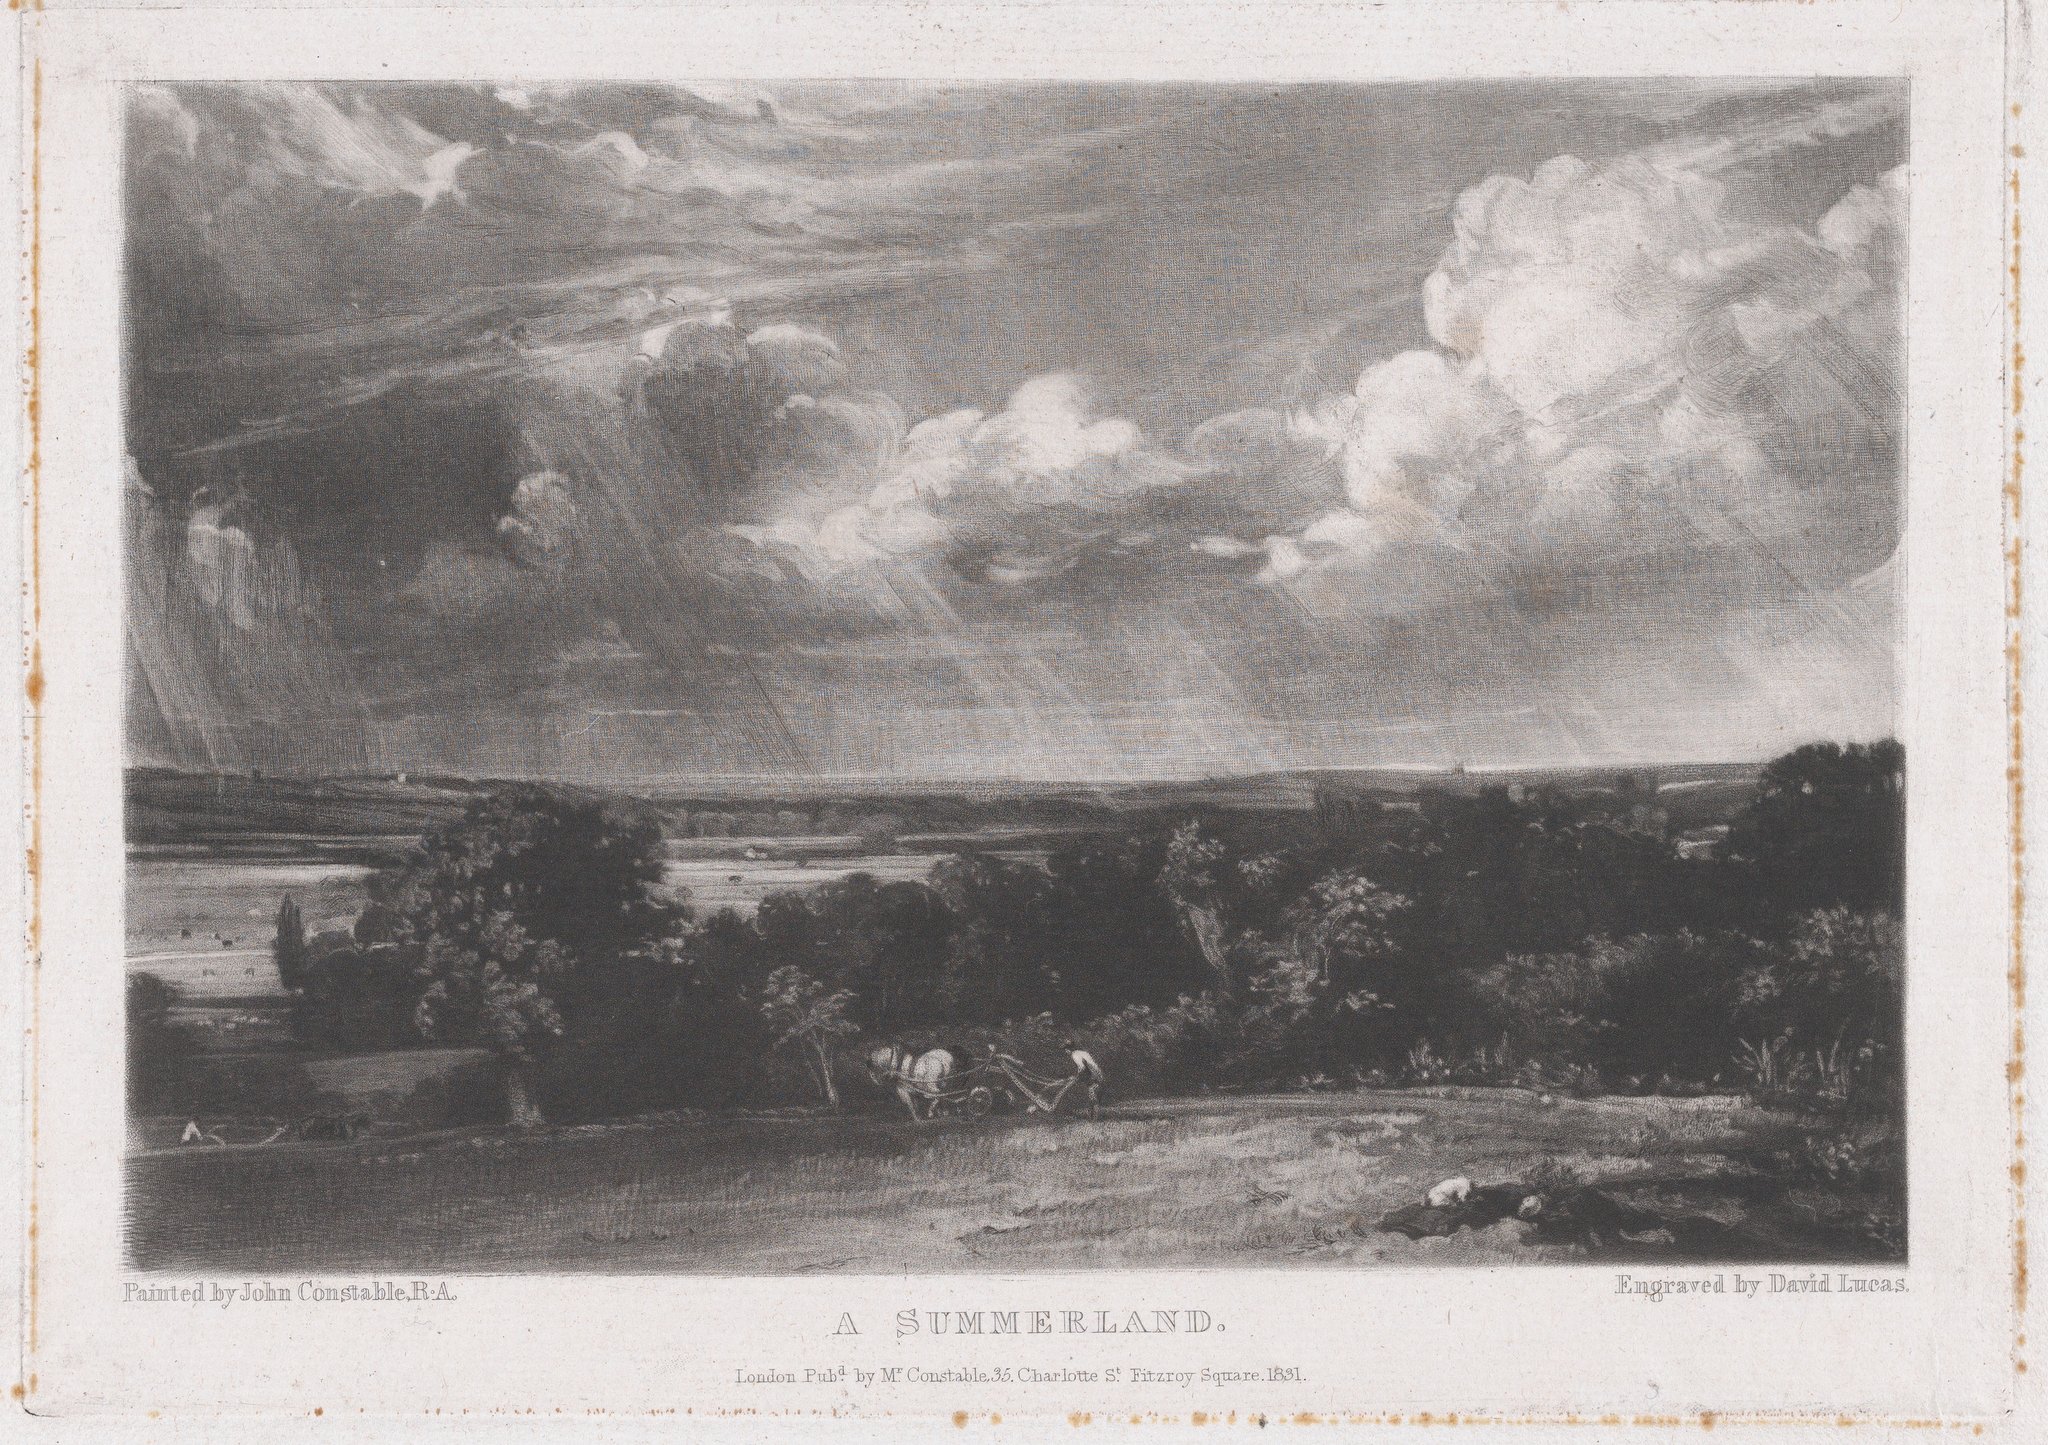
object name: print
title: A Summerland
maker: david lucas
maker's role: artist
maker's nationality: british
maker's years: 1802-1881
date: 1831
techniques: mezzotint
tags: animals,men,landscapes,trees